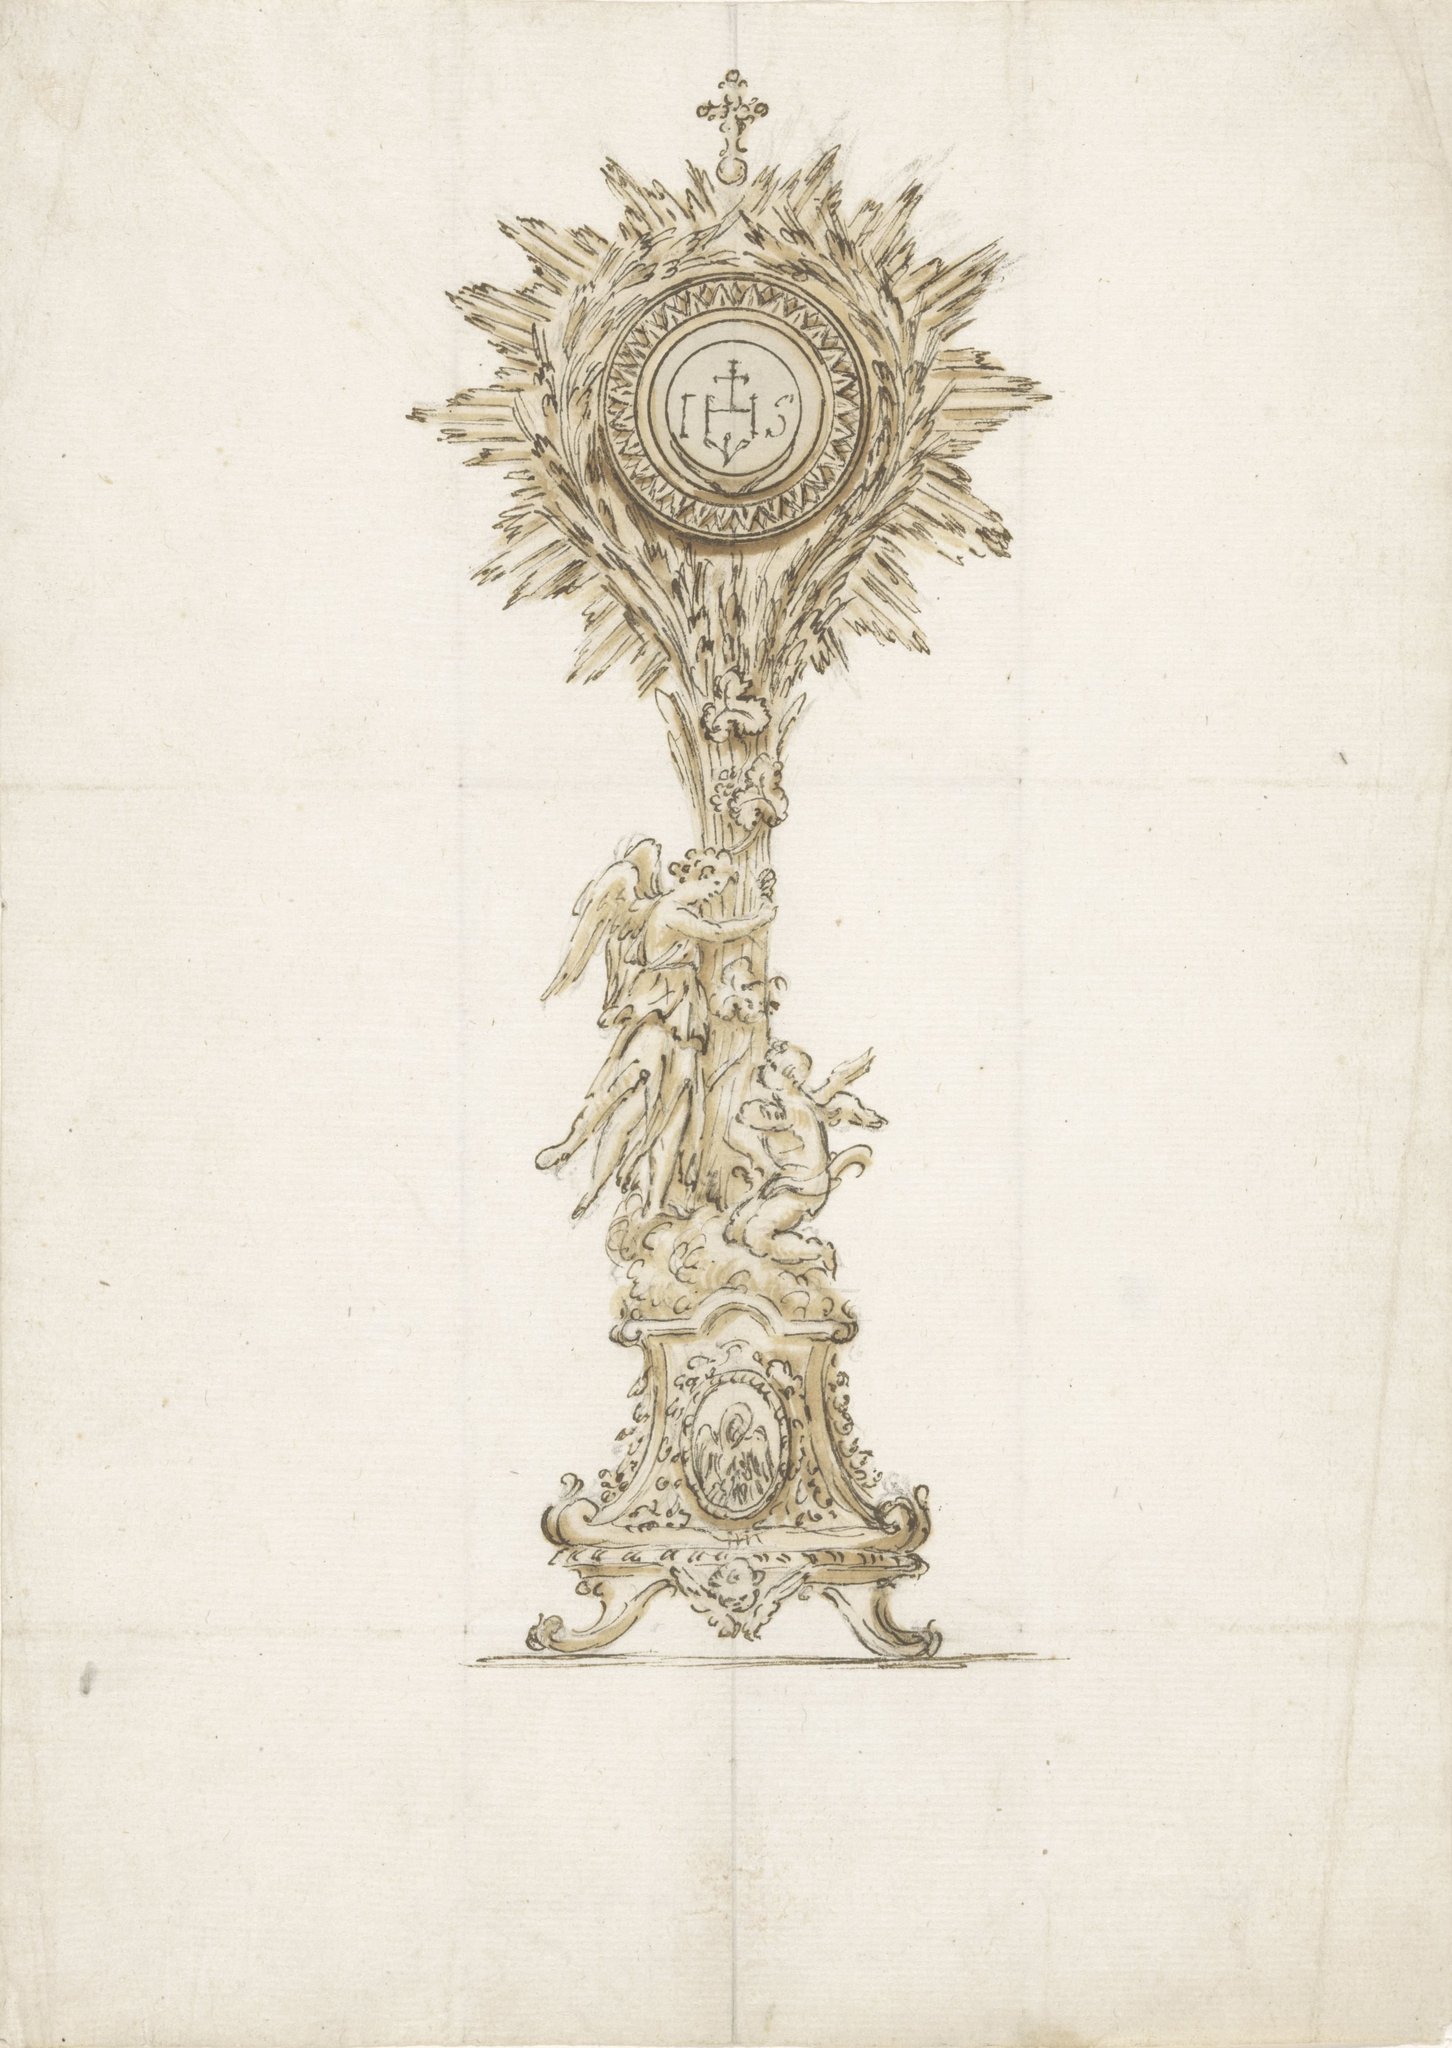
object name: design drawing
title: Ontwerp voor een stralenmonstrans met het monogram IHS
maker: luigi valadier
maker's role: draughtsman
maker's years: 1726-1785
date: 1760-1770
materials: ink, paper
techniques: brush, pen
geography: rome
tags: ostensorium, monstrance